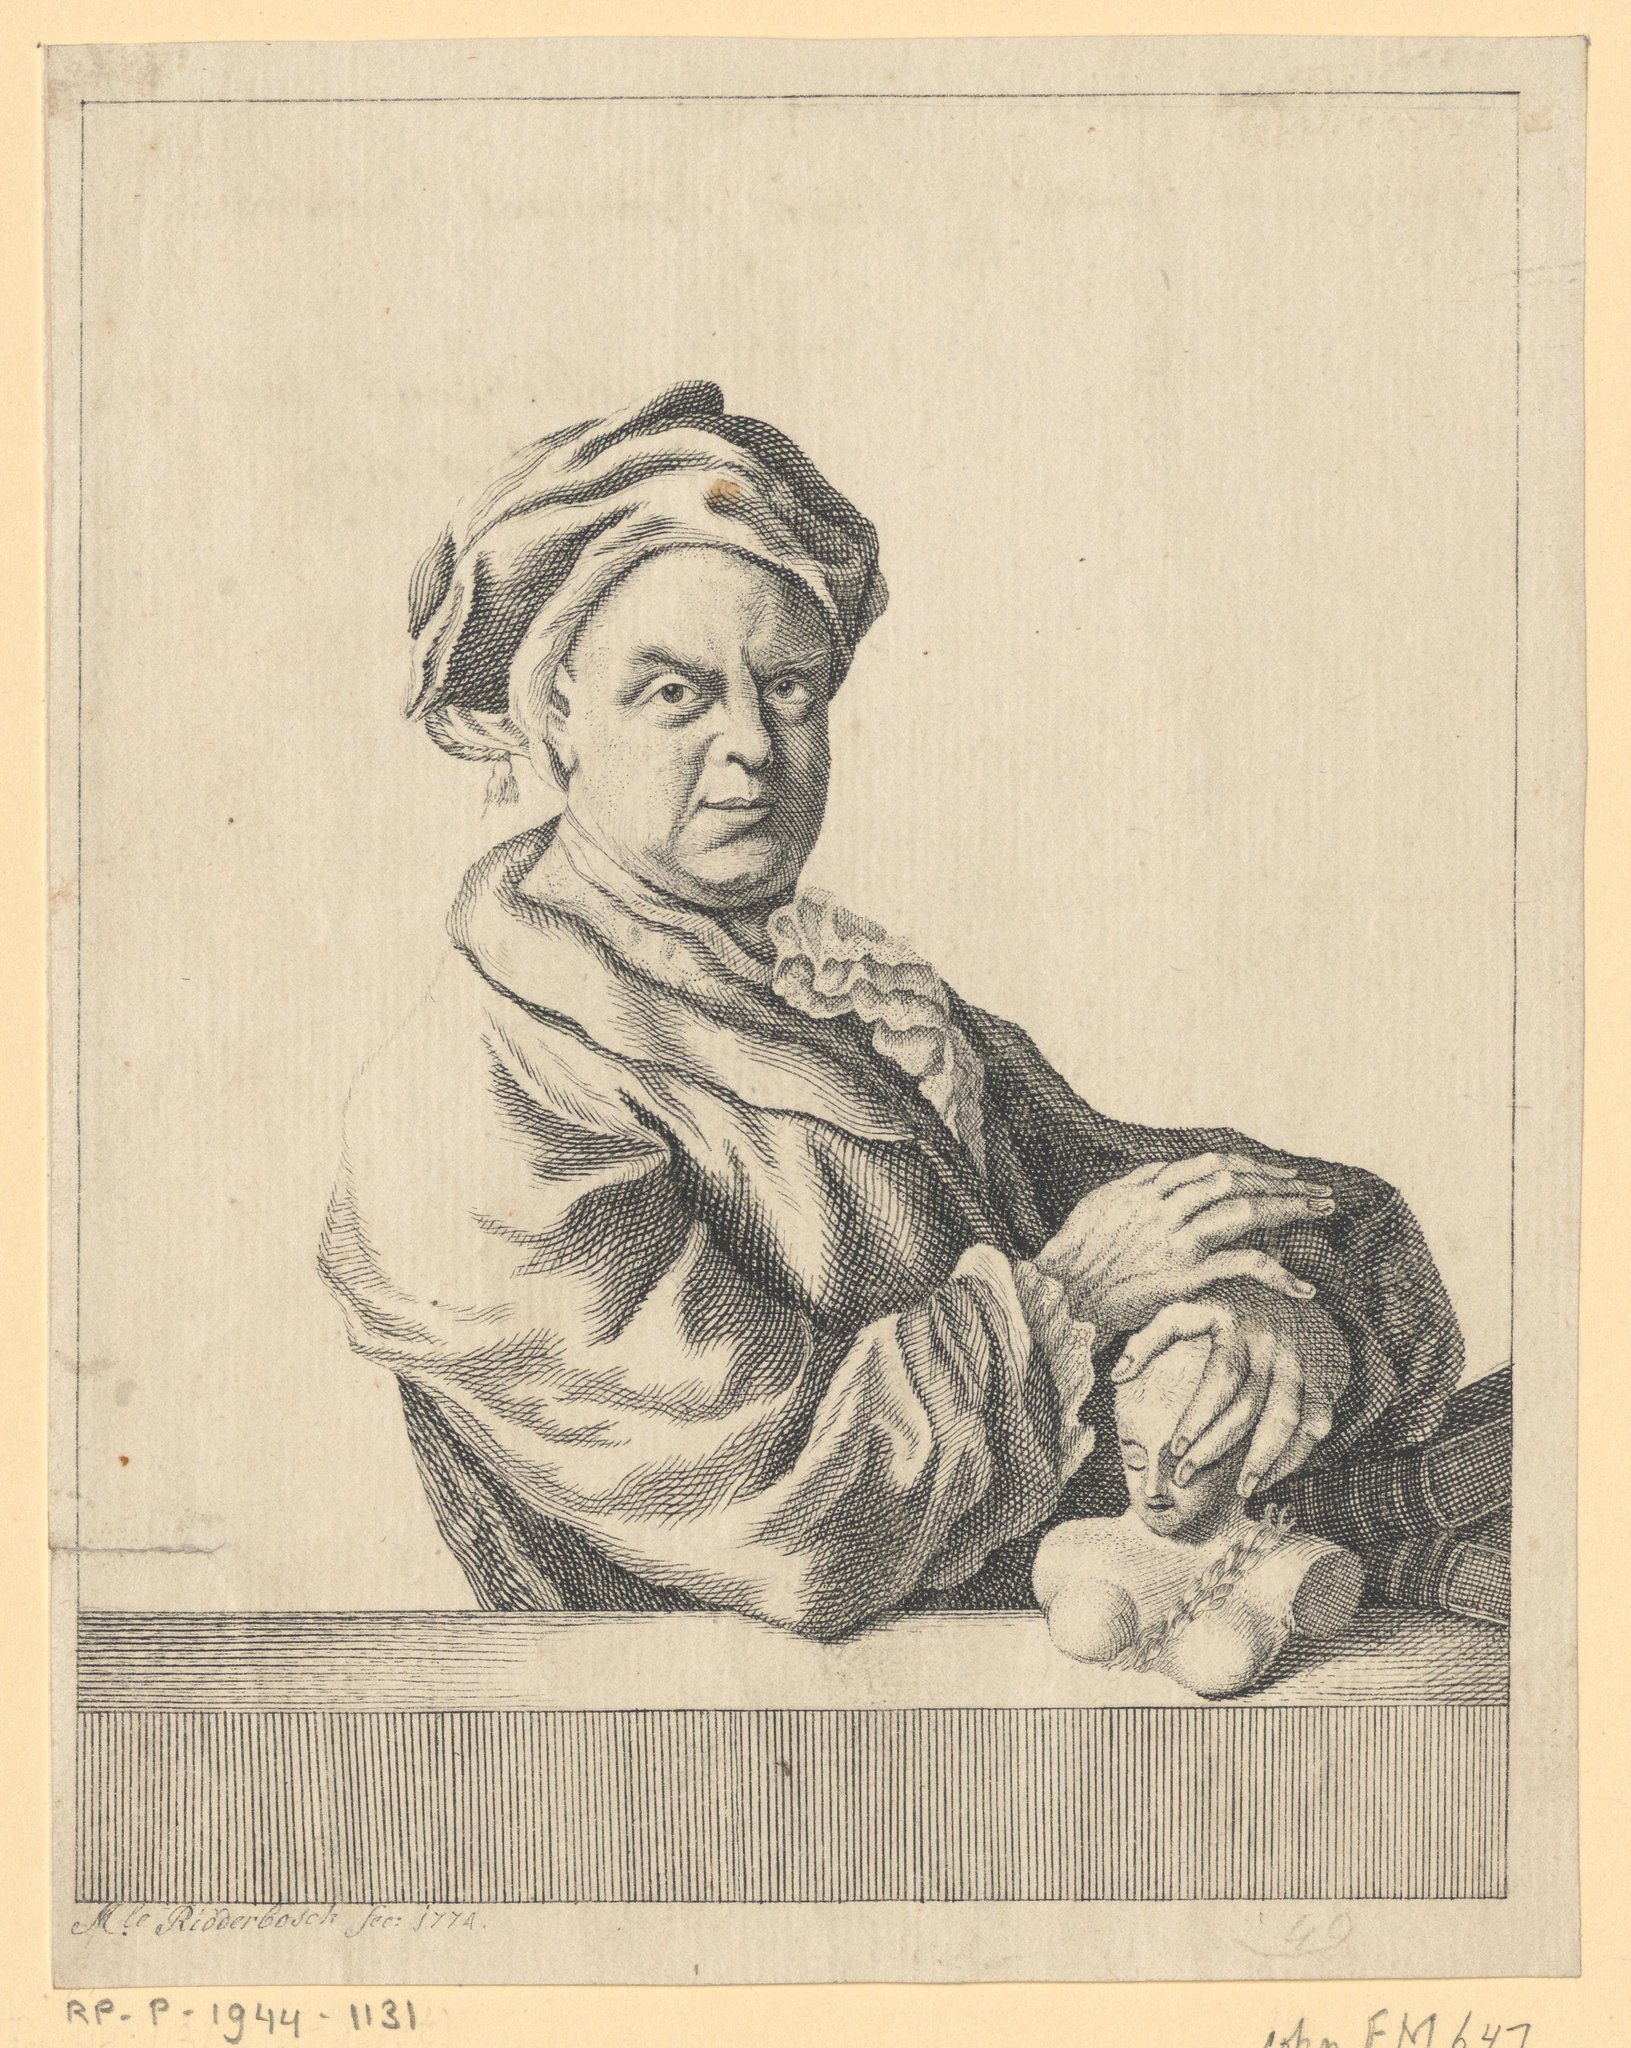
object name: drawing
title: Portret van Gerret Braamcamp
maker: françoise jeanne ridderbosch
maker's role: draughtsman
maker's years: 1754-1837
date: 1774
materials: paper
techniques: pen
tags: amsterdam, gerret braamcamp, historical persons, art collector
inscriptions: collector's mark: Lugt 2228, inscription: ‘Dees bussel/ printen hoort toe aen Joannes Jacobsch de/ Wilde geteekent den 17/ iulius 1805’